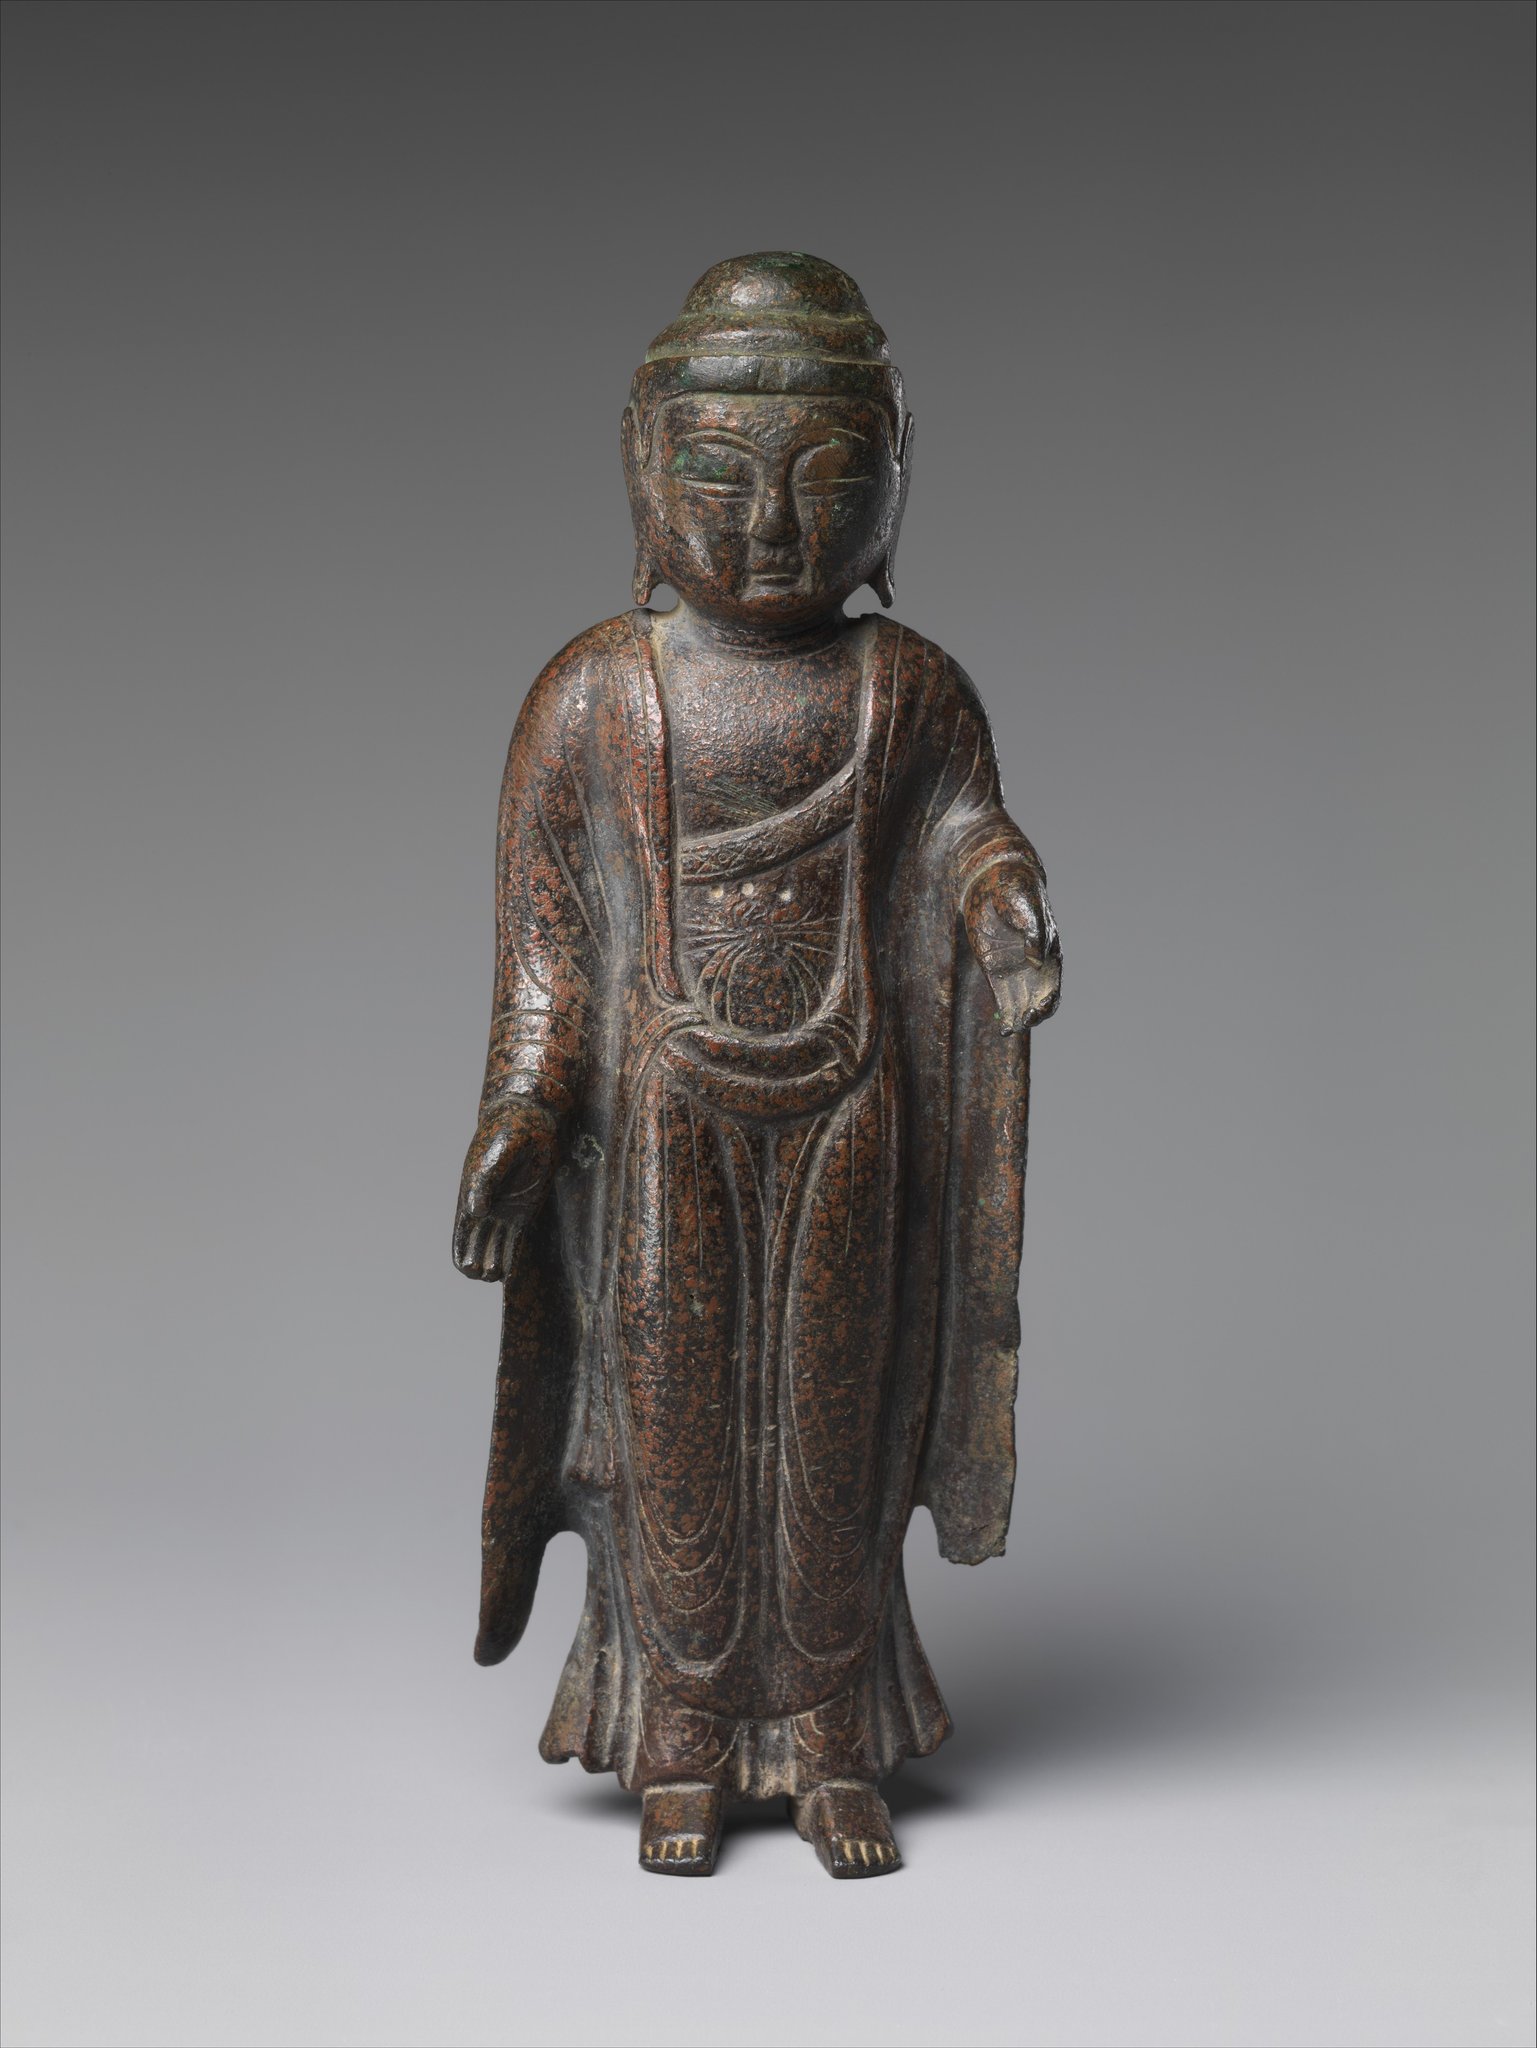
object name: figure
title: Standing Buddha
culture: korean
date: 801-900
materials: bronze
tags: buddhism,buddha